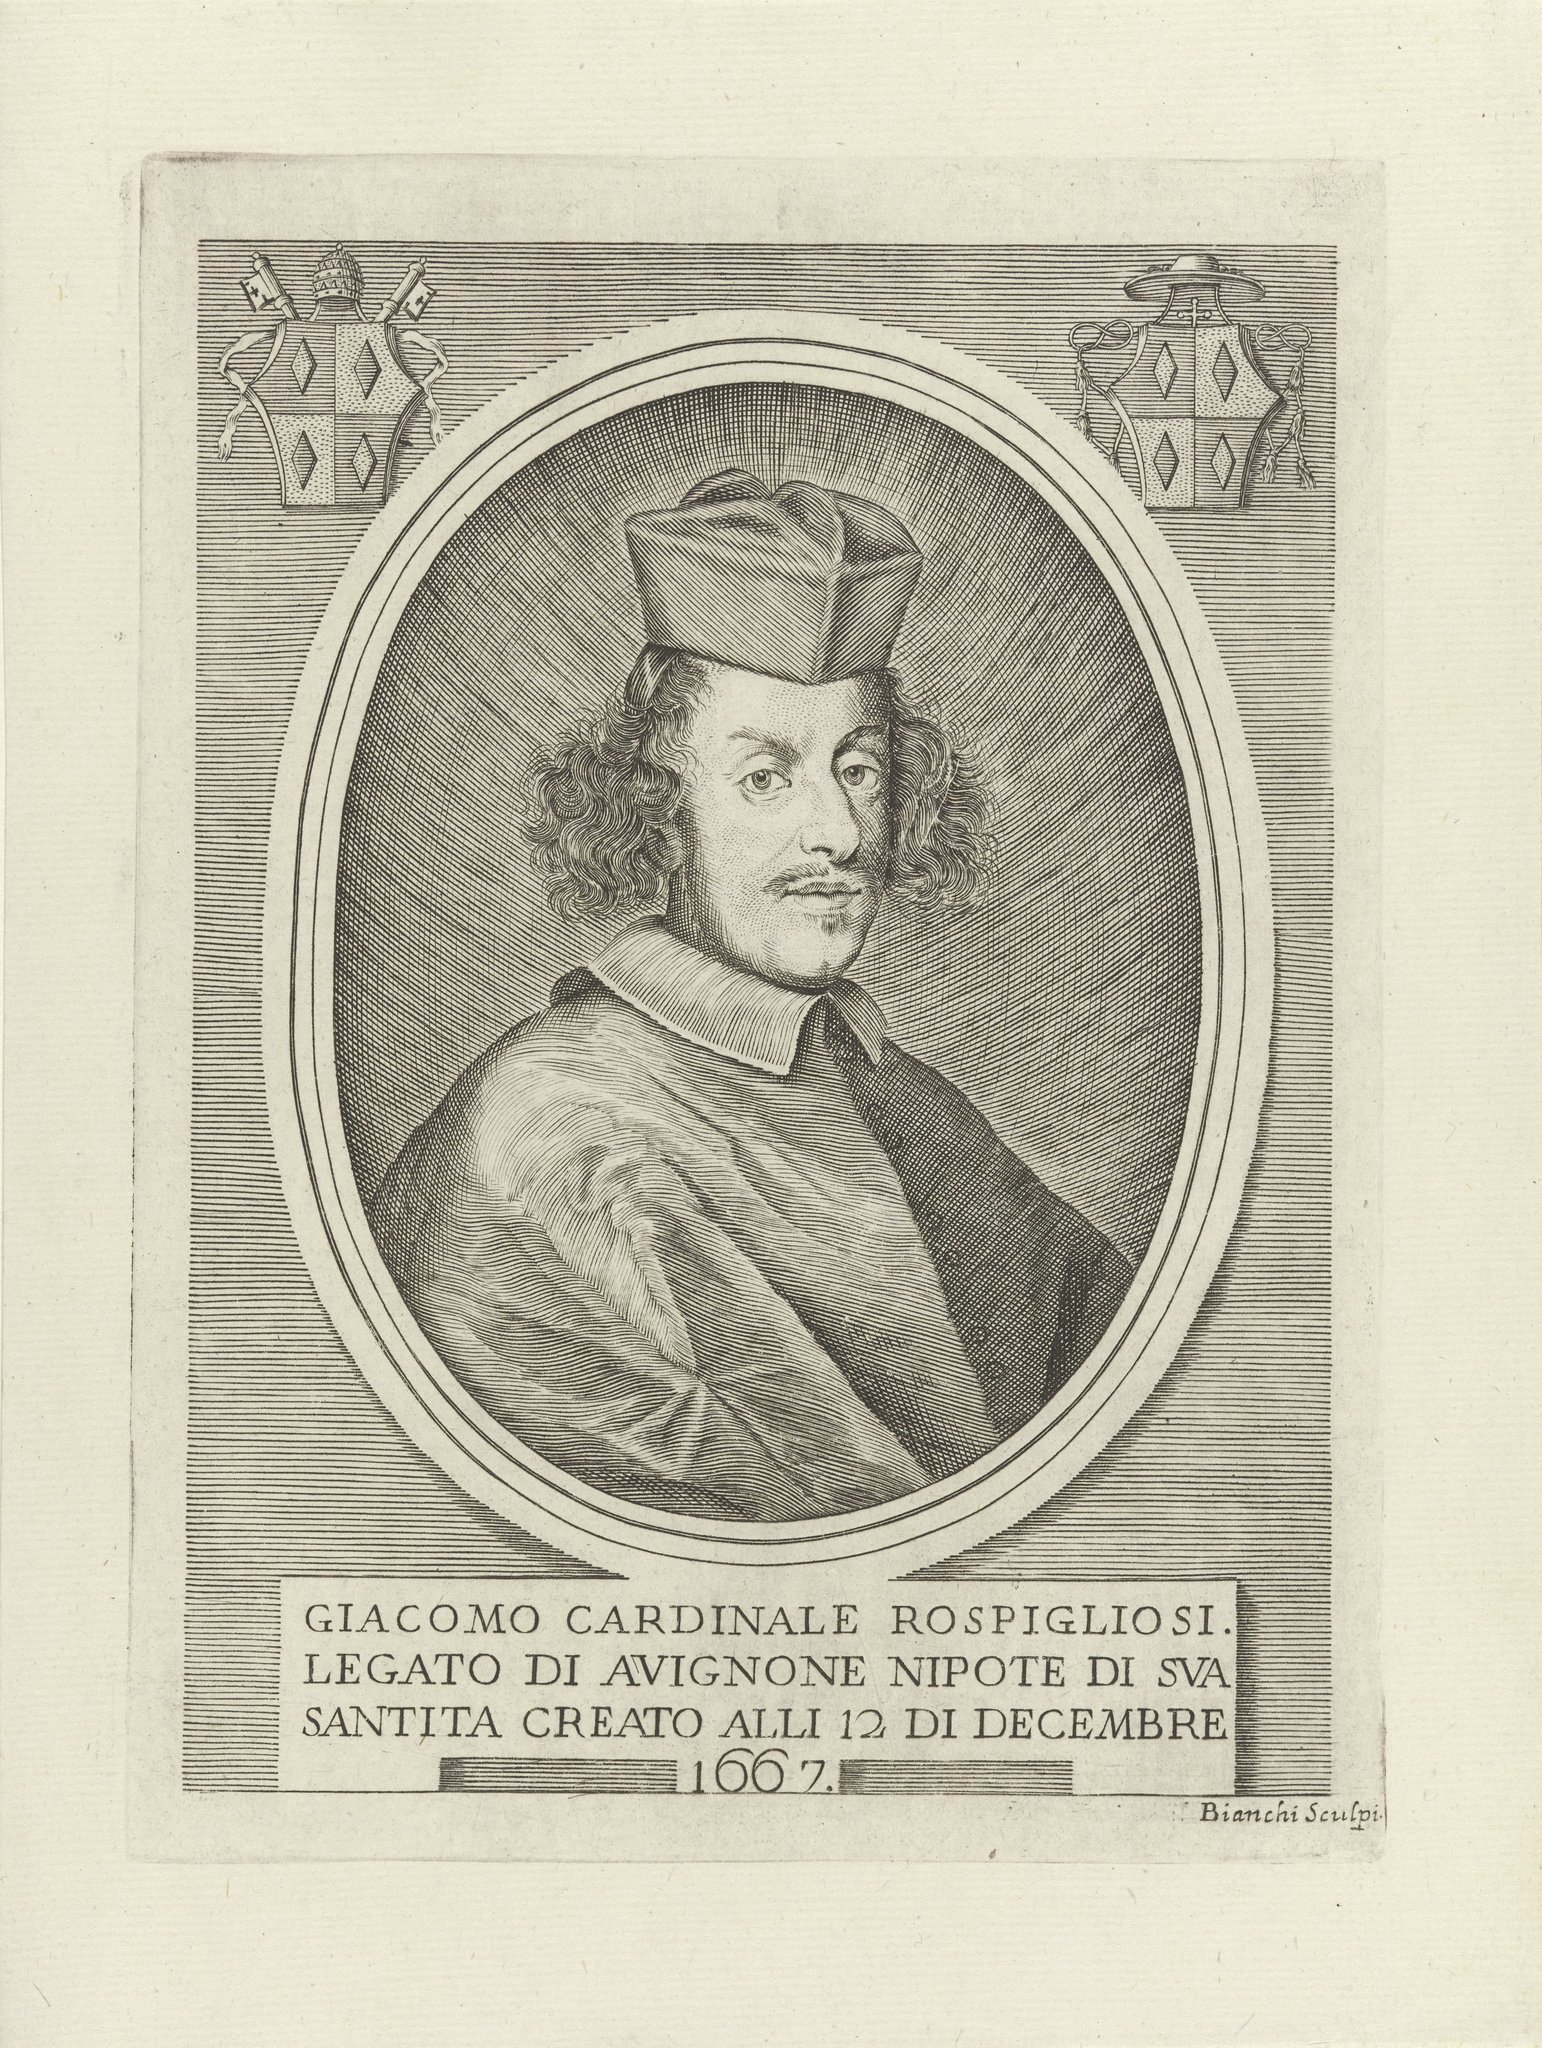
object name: print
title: Portret van kardinaal Giacomo Rospigliosi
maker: giulio cesare bianchi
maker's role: print maker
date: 1771-1781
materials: paper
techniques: engraving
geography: italy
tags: cardinal, historical persons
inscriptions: collector's mark: Lugt 2228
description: Prent uit een reeks van onbekende omvang met portretten van kardinalen. De prenten werden vanaf 1657 vervaardigd in opdracht van uitgever Giovanni Giacomo de’ Rossi, waarna de productie werd voortgezet onder leiding van zijn opvolgers Domenico de’ Rossi en Lorenzo Filippo de’ Rossi, en tenslotte onder leiding van de Calcographia R.C.A.